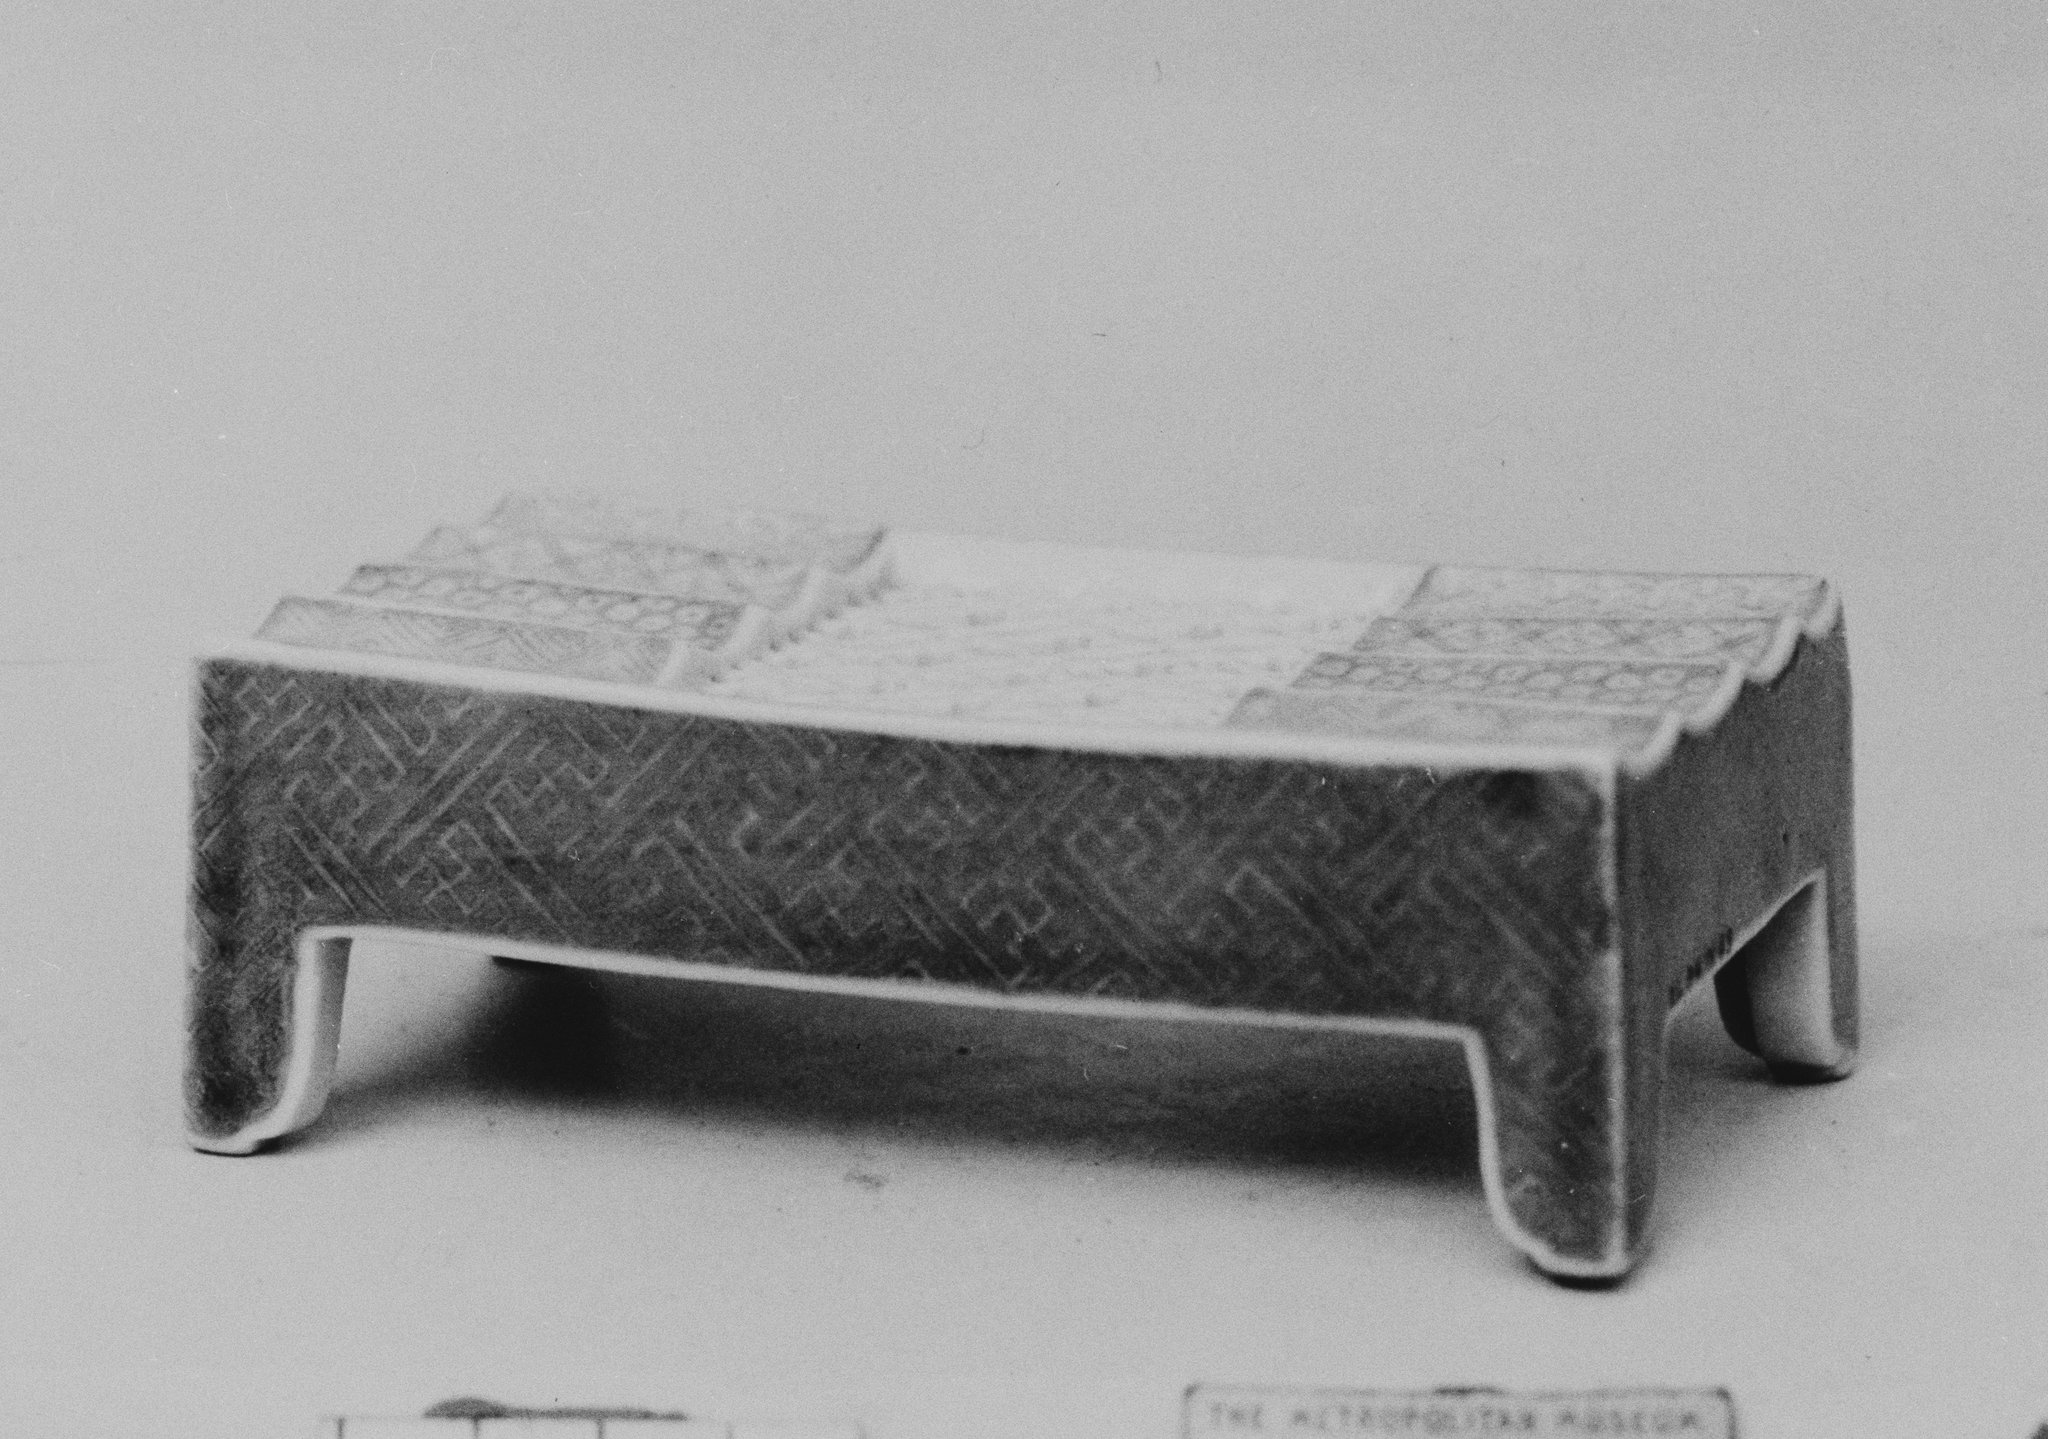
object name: inkstand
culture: japanese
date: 1800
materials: glaze, porcelain